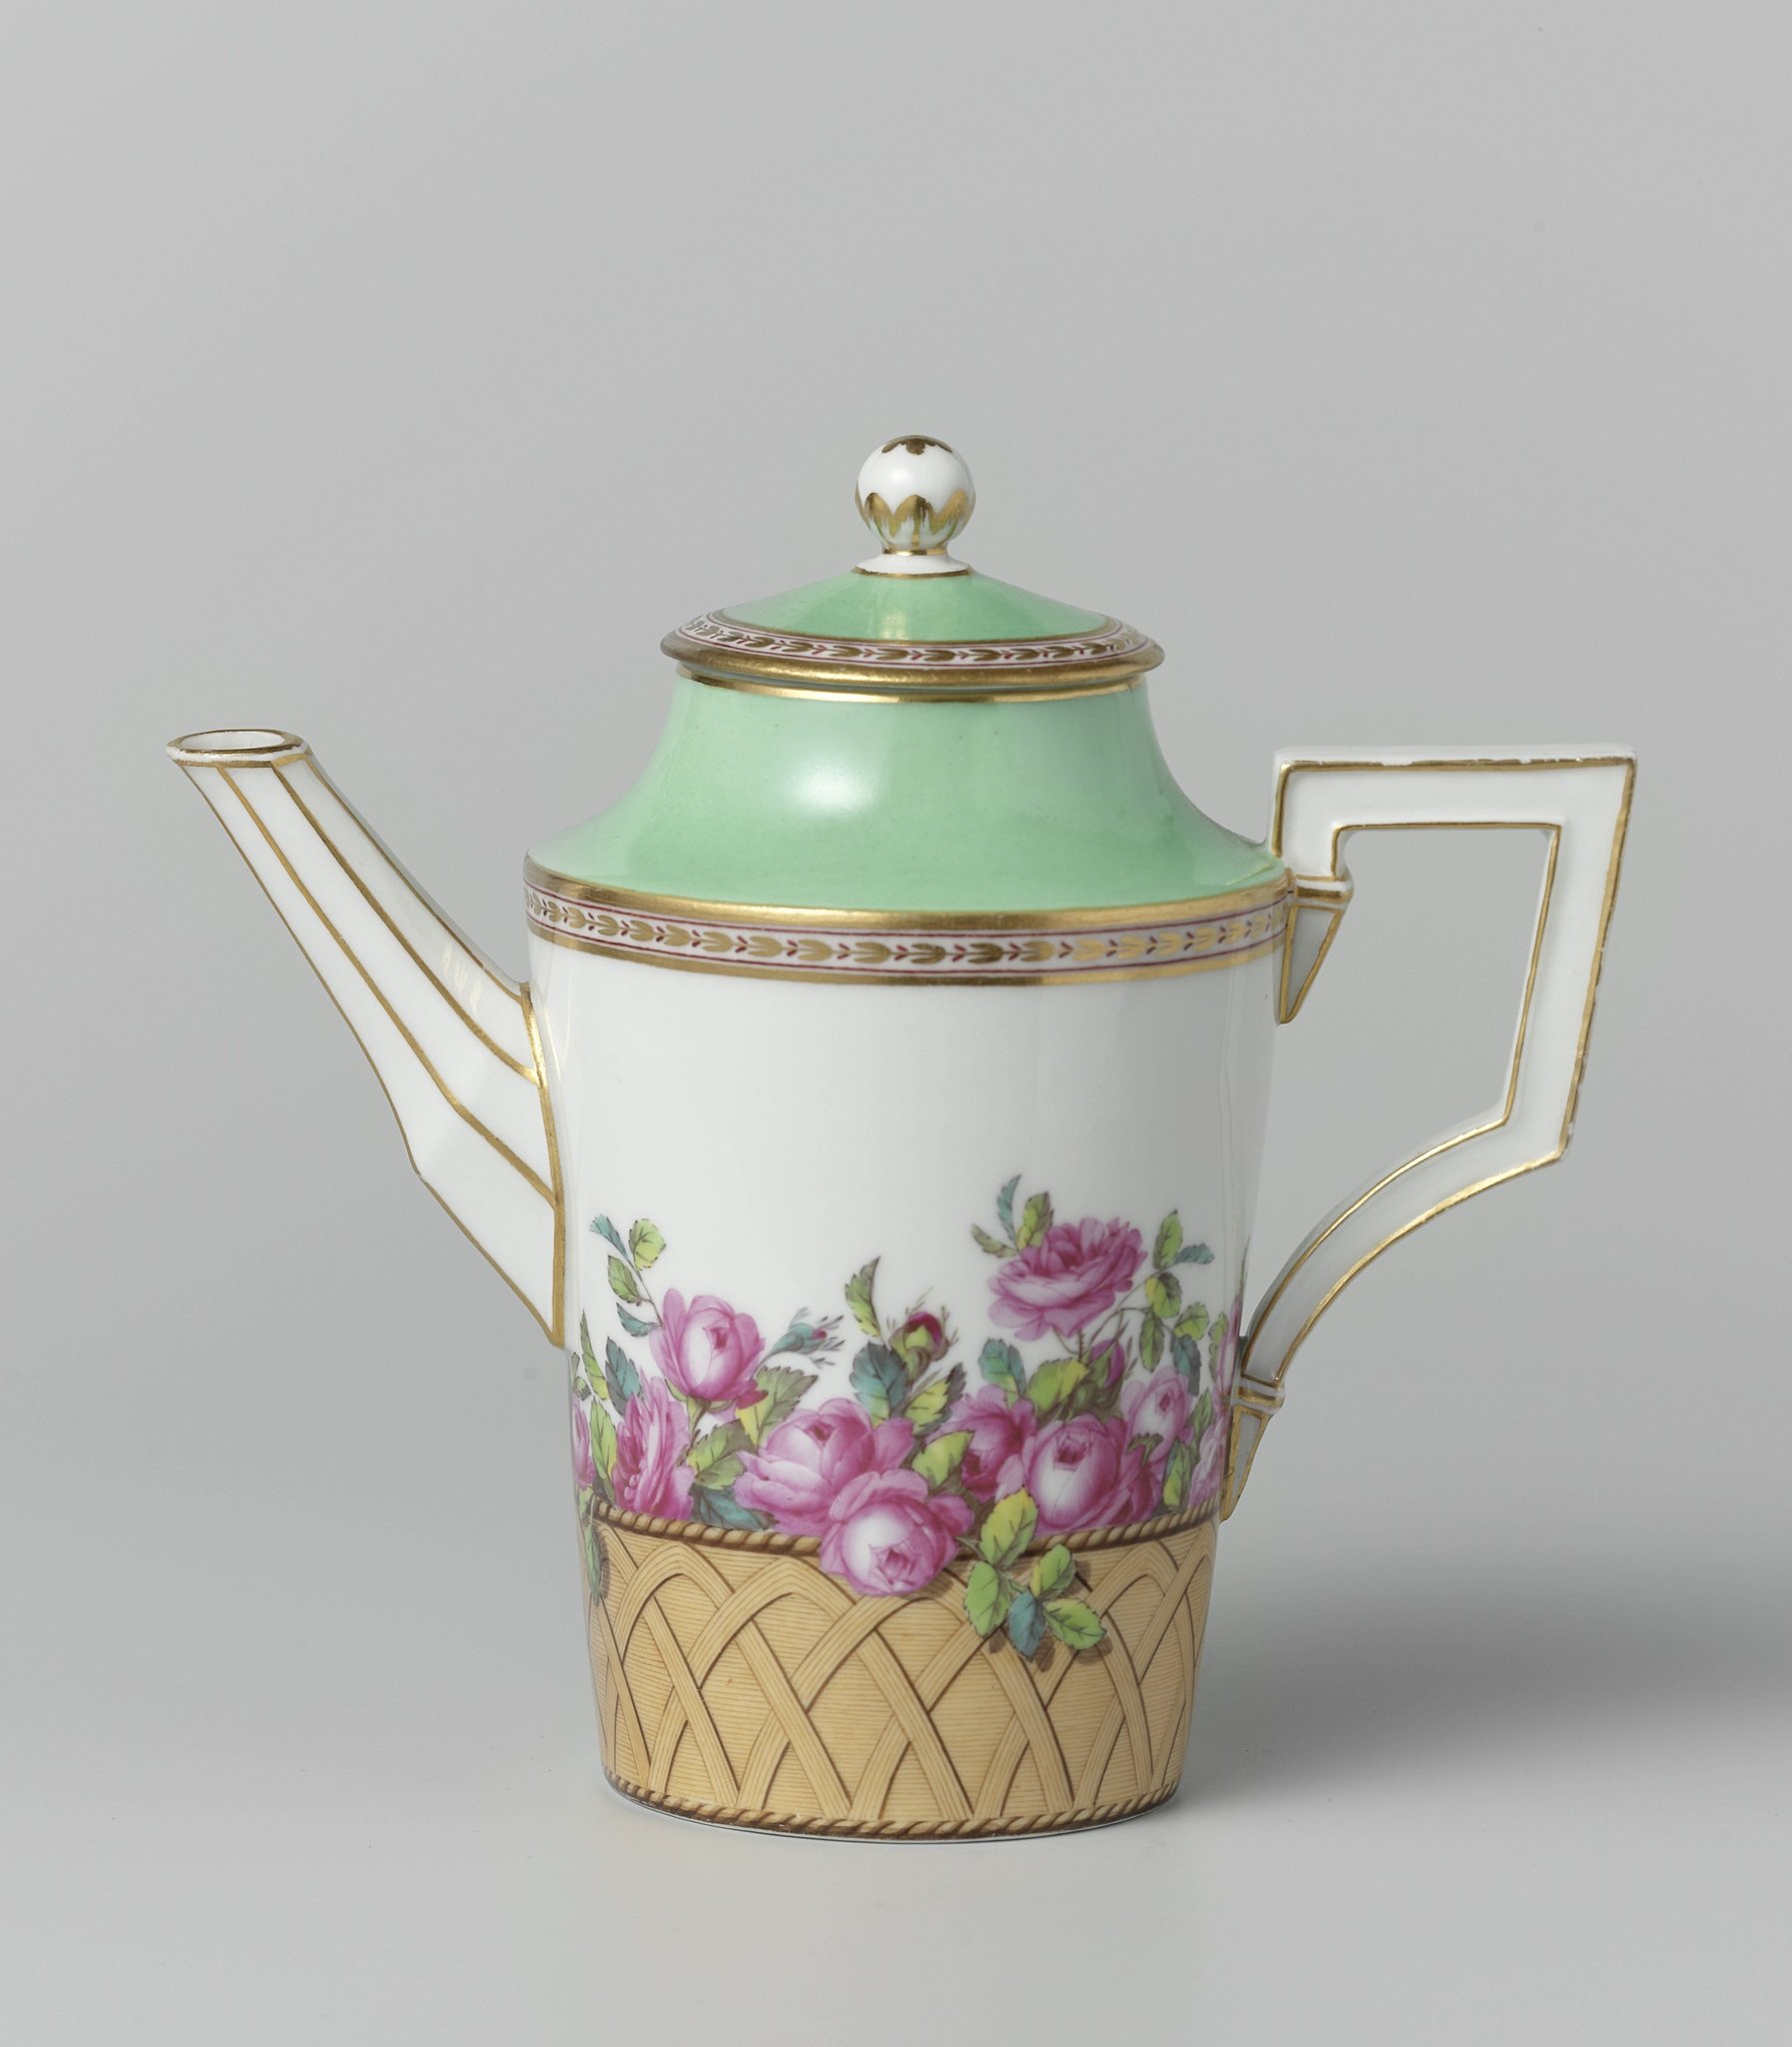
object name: coffee pot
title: Coffeepot with roses in a basket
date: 1795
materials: glaze, gold, porcelain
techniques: firing, forming, gilding, turning, vitrification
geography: berlin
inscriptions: mark: ‘scepter/ driehoek/ 34/ V’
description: Parts of a tea and coffee service. Porcelain. Berlin, c. 1790 - 1800.